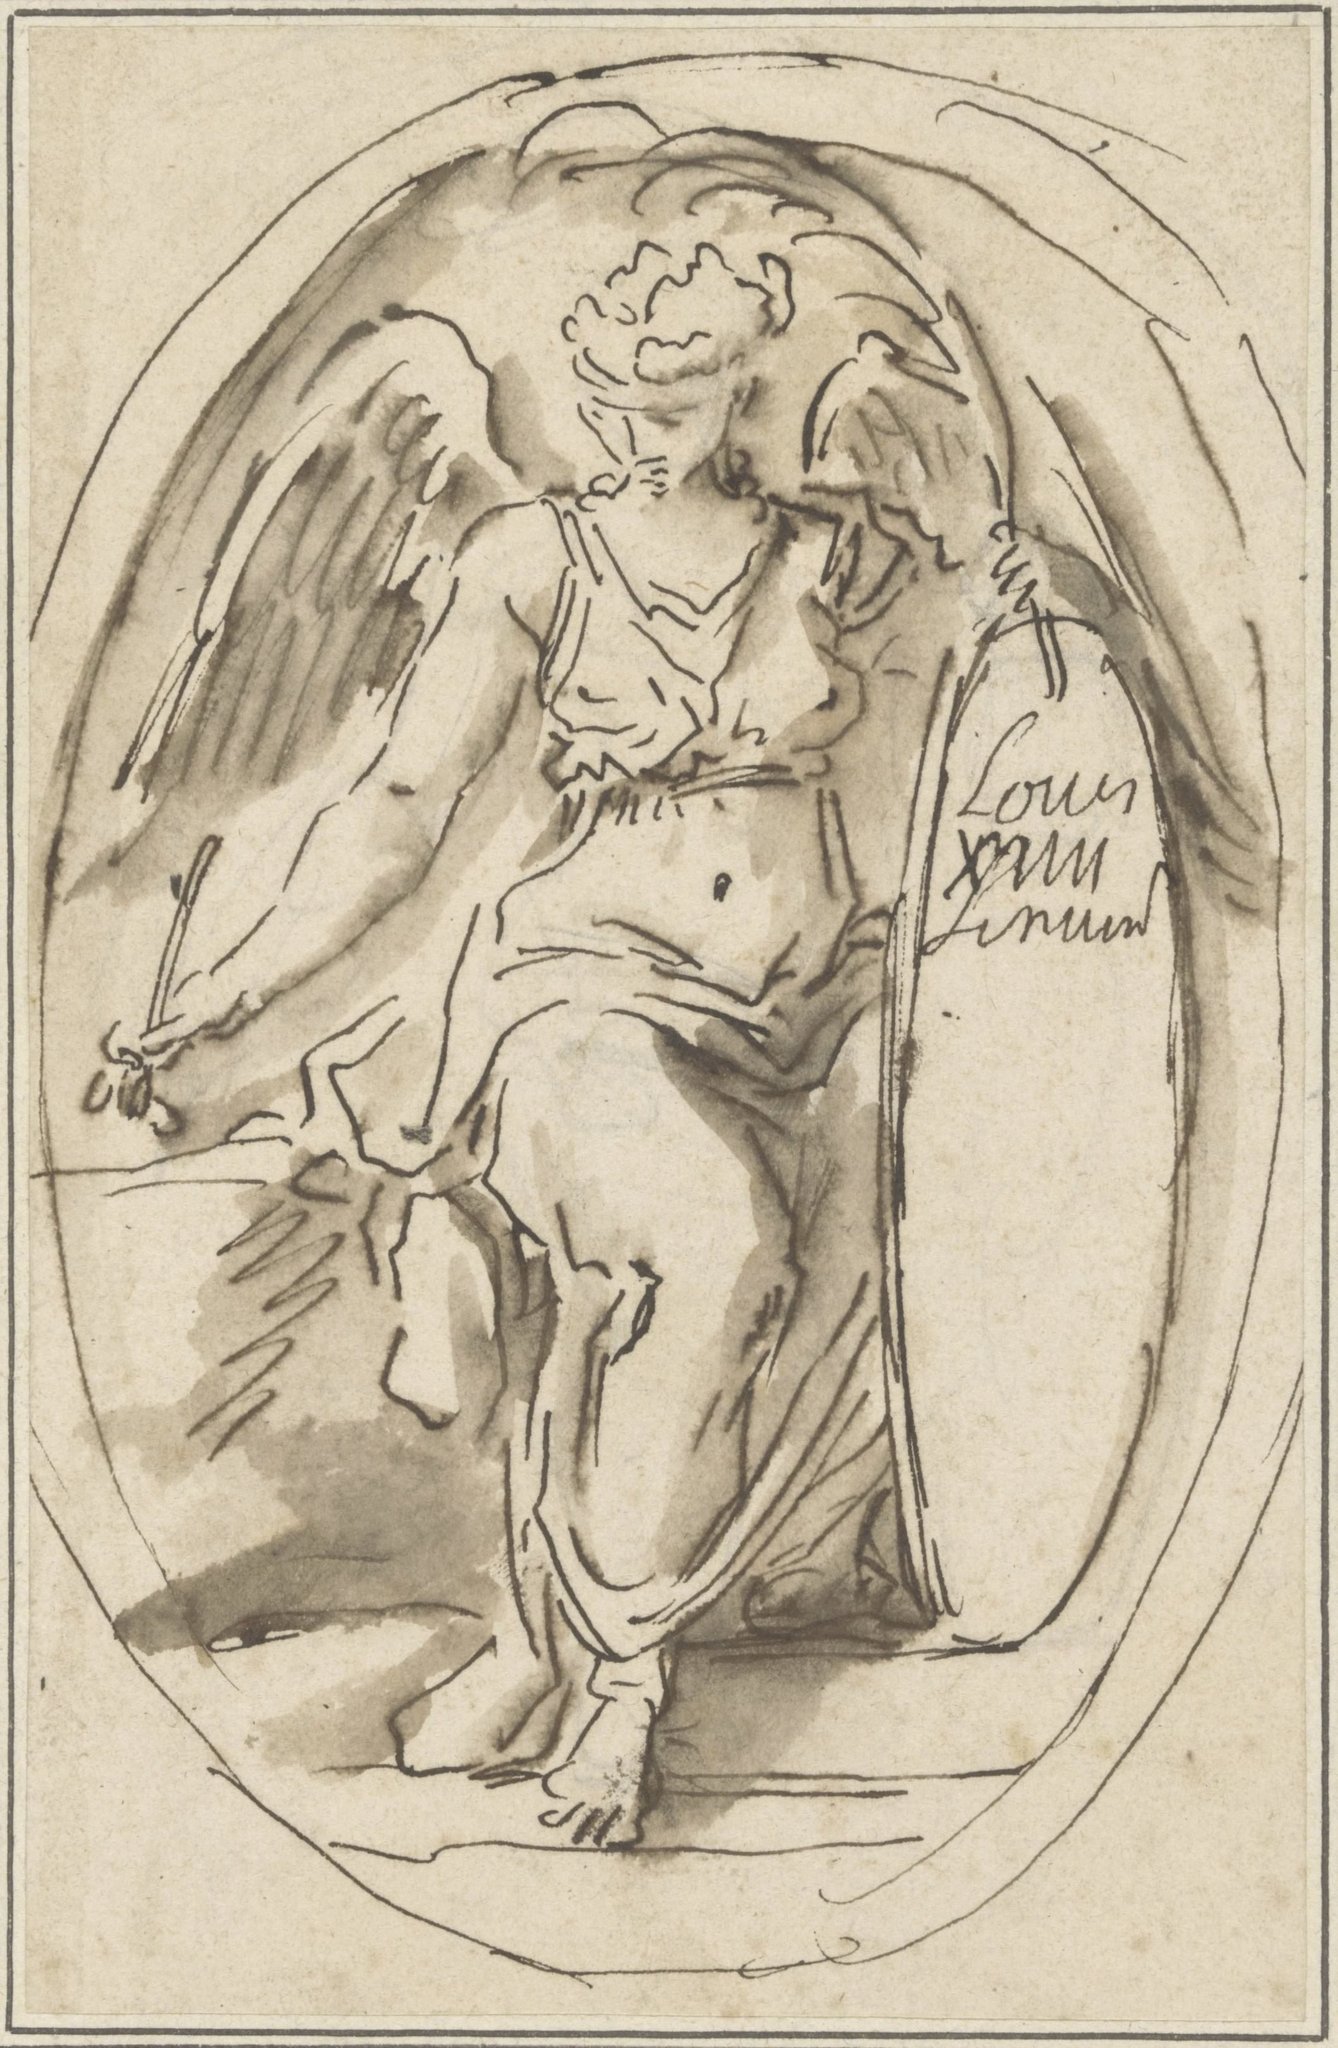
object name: drawing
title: Schrijvende engel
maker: Anonymous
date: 1770-1799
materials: ink, paper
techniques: brush, pen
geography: france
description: Een schrijvende engel in een ovale omlijsting. Ontwerp voor een grafmonument.